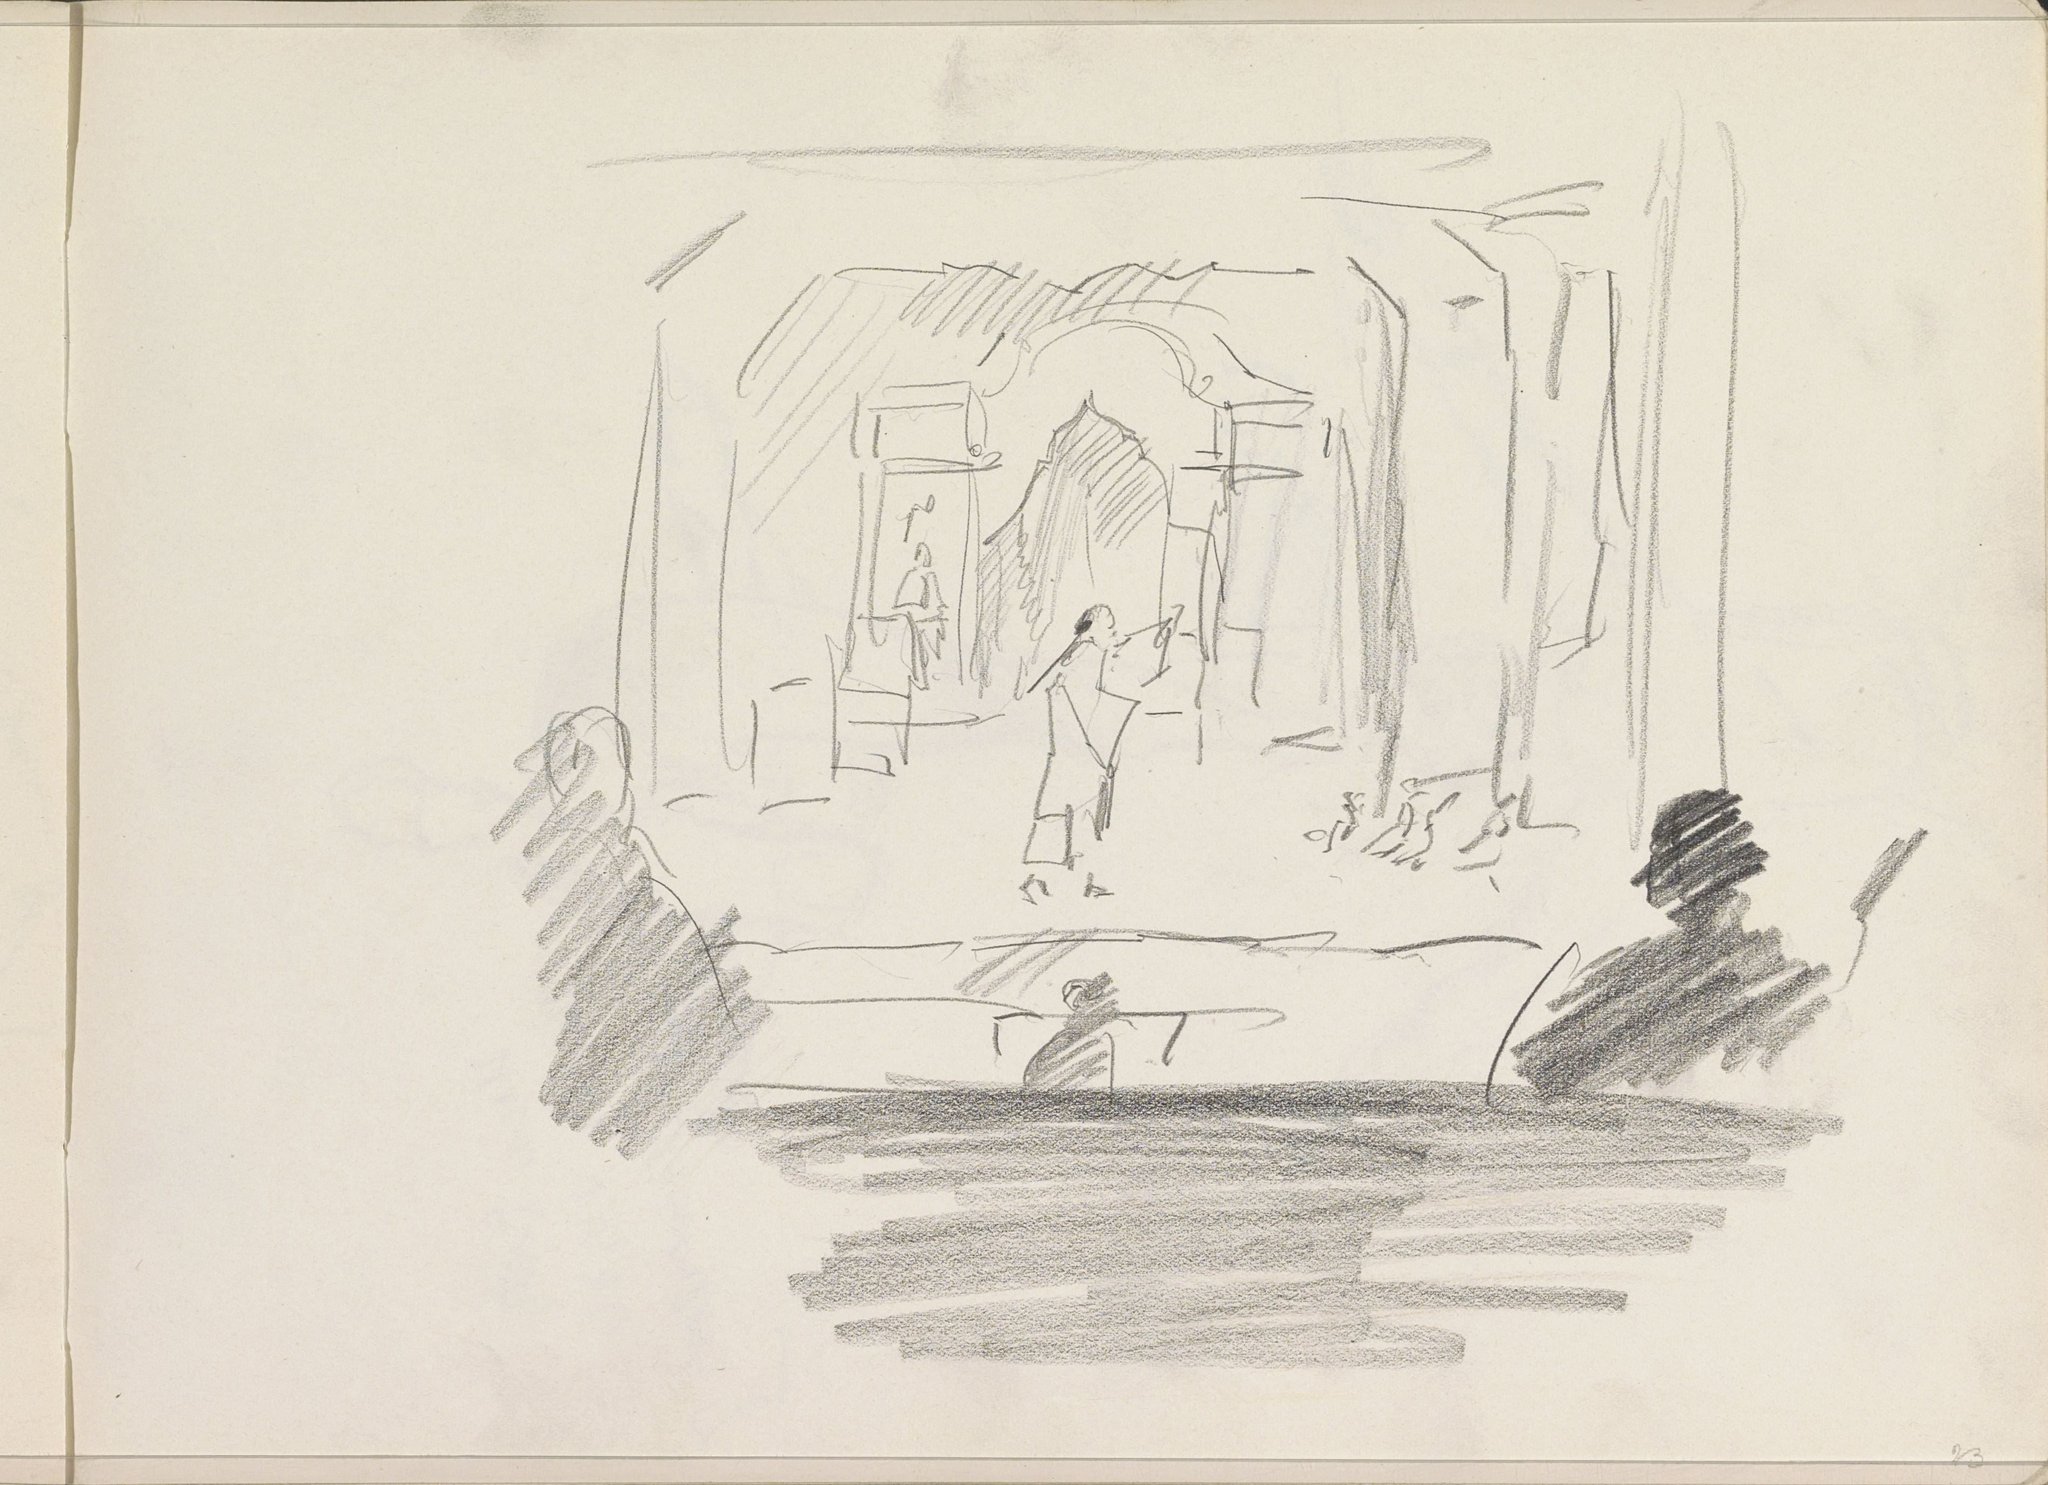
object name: sketchbook leaf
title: Theatervoorstelling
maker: isaac israels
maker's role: draughtsman, painter, print maker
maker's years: 1865-1934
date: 1875-1934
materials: paper, pencil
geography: the hague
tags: theatre, theatrical performance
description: Figuren op het toneel. In het midden een dirigent in de orkestbak. Vooraan toeschouwers. Blad 23 recto uit schetsboek V met 33 bladen.